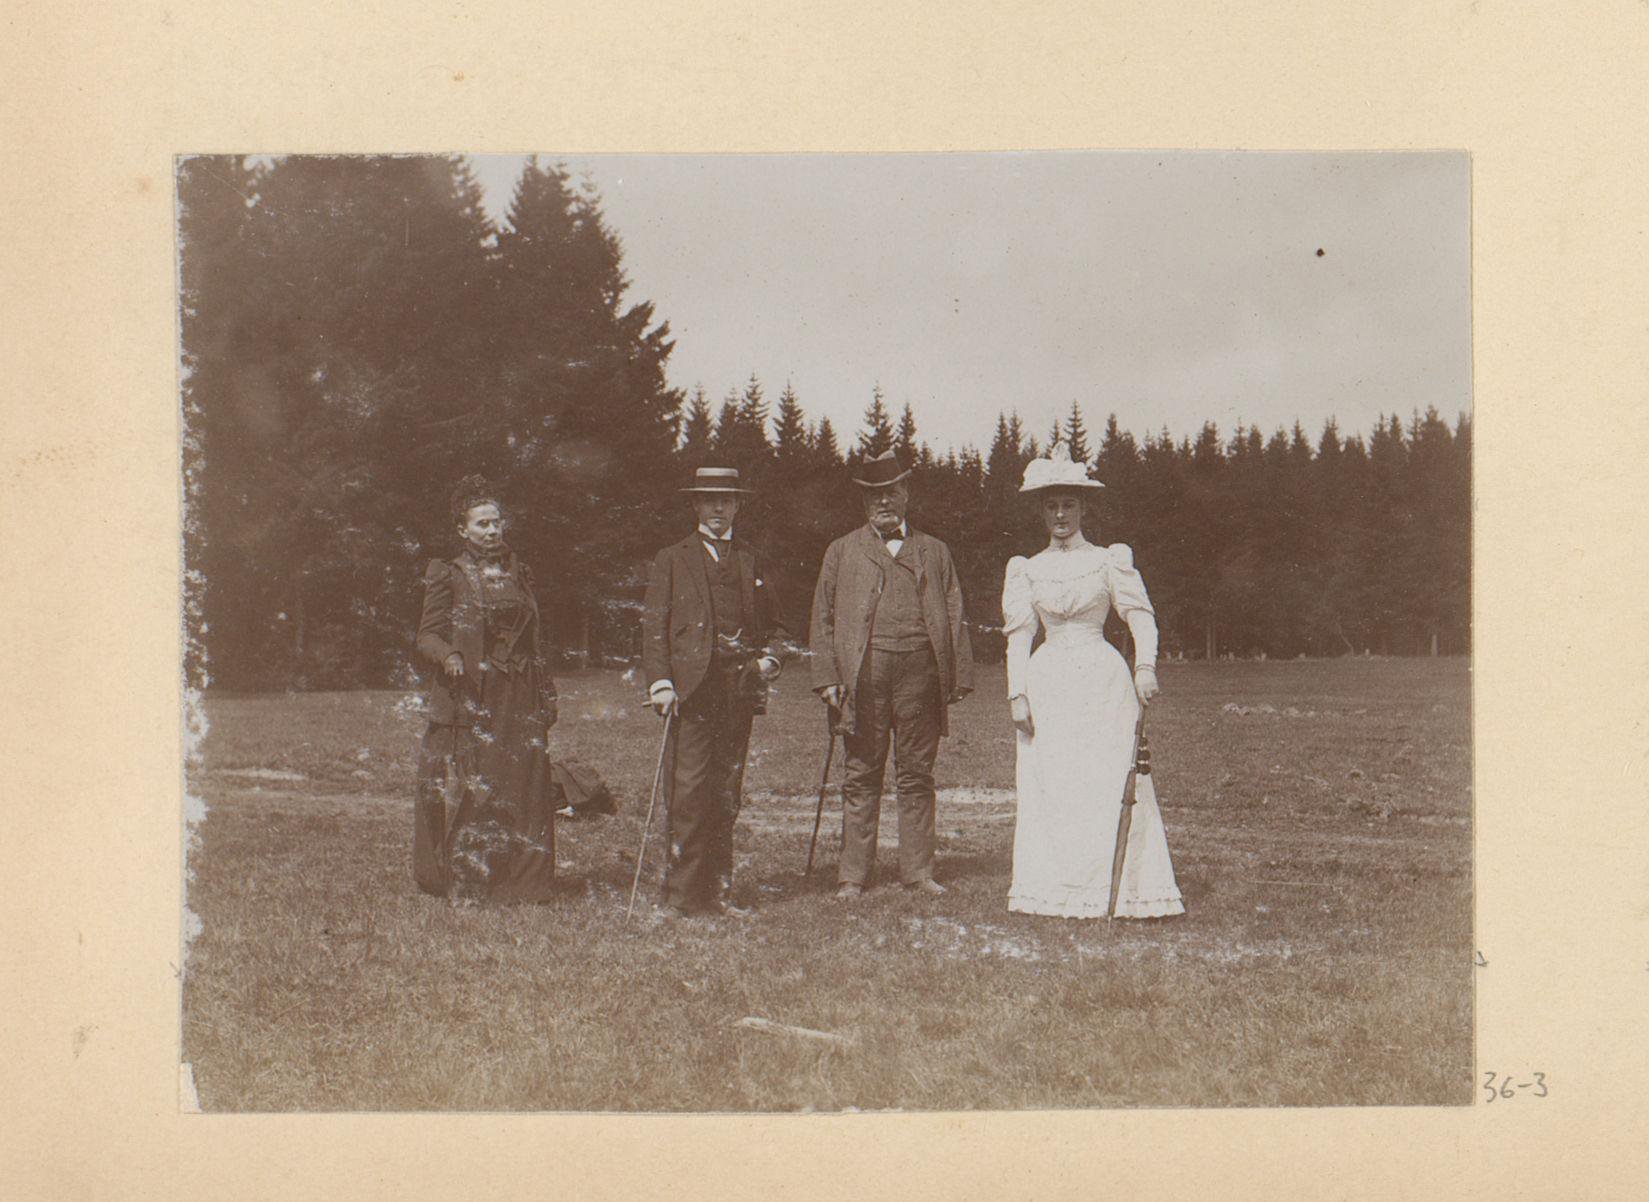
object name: photograph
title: Familieportret op een weide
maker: hendrik herman van den berg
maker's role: amateurfotograaf, jurist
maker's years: 1875-1944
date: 1890-1894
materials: paper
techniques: collodion silver print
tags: family group, especially parents with their child(ren), historical persons, amsterdam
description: Foto 3 op albumblad 36 uit album "Amsterdam 1890-1894".